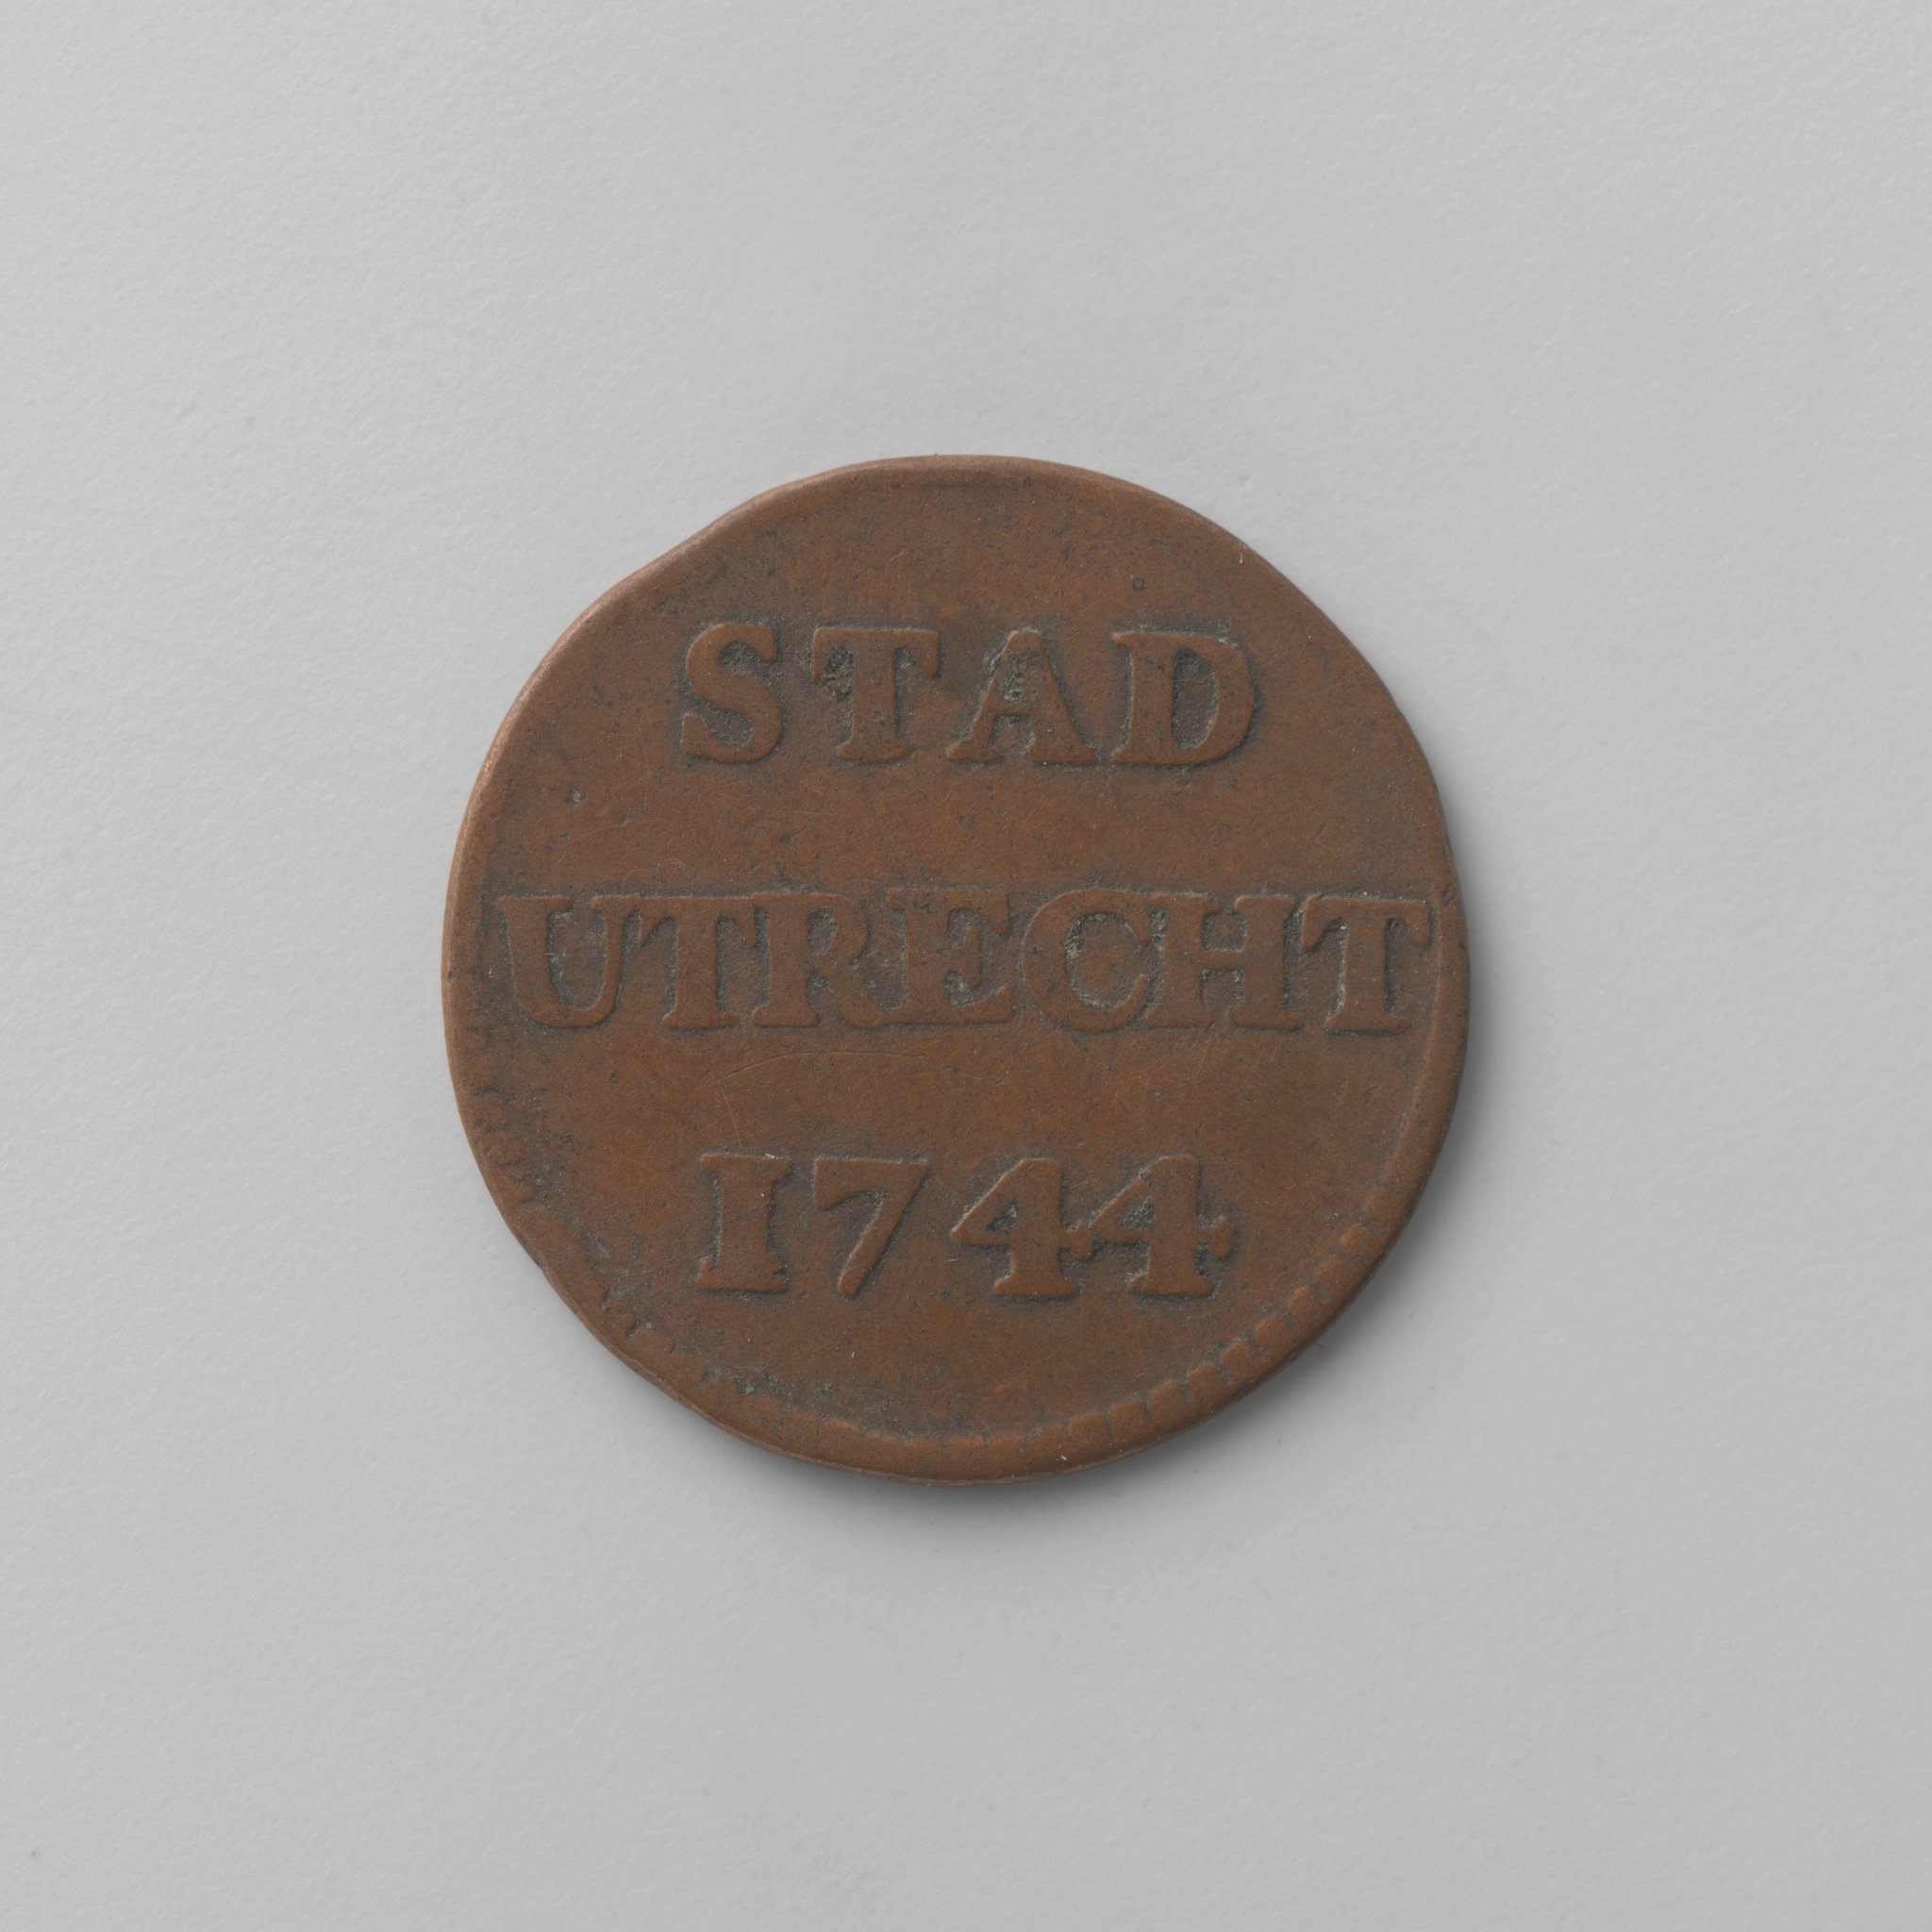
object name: coin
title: Duit van de stad Utrecht, 1744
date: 1744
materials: copper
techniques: striking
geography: utrecht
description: Koperen munt. Voorzijde: gekroond stedelijk wapenschild, gehouden door twee leeuwen met in afsnede dunne lijn, waaronder een versierde accolade met een grote schelp. Keerzijde: opschrift in twee regels, waaronder jaartal. Jaartal met Romeinse I.